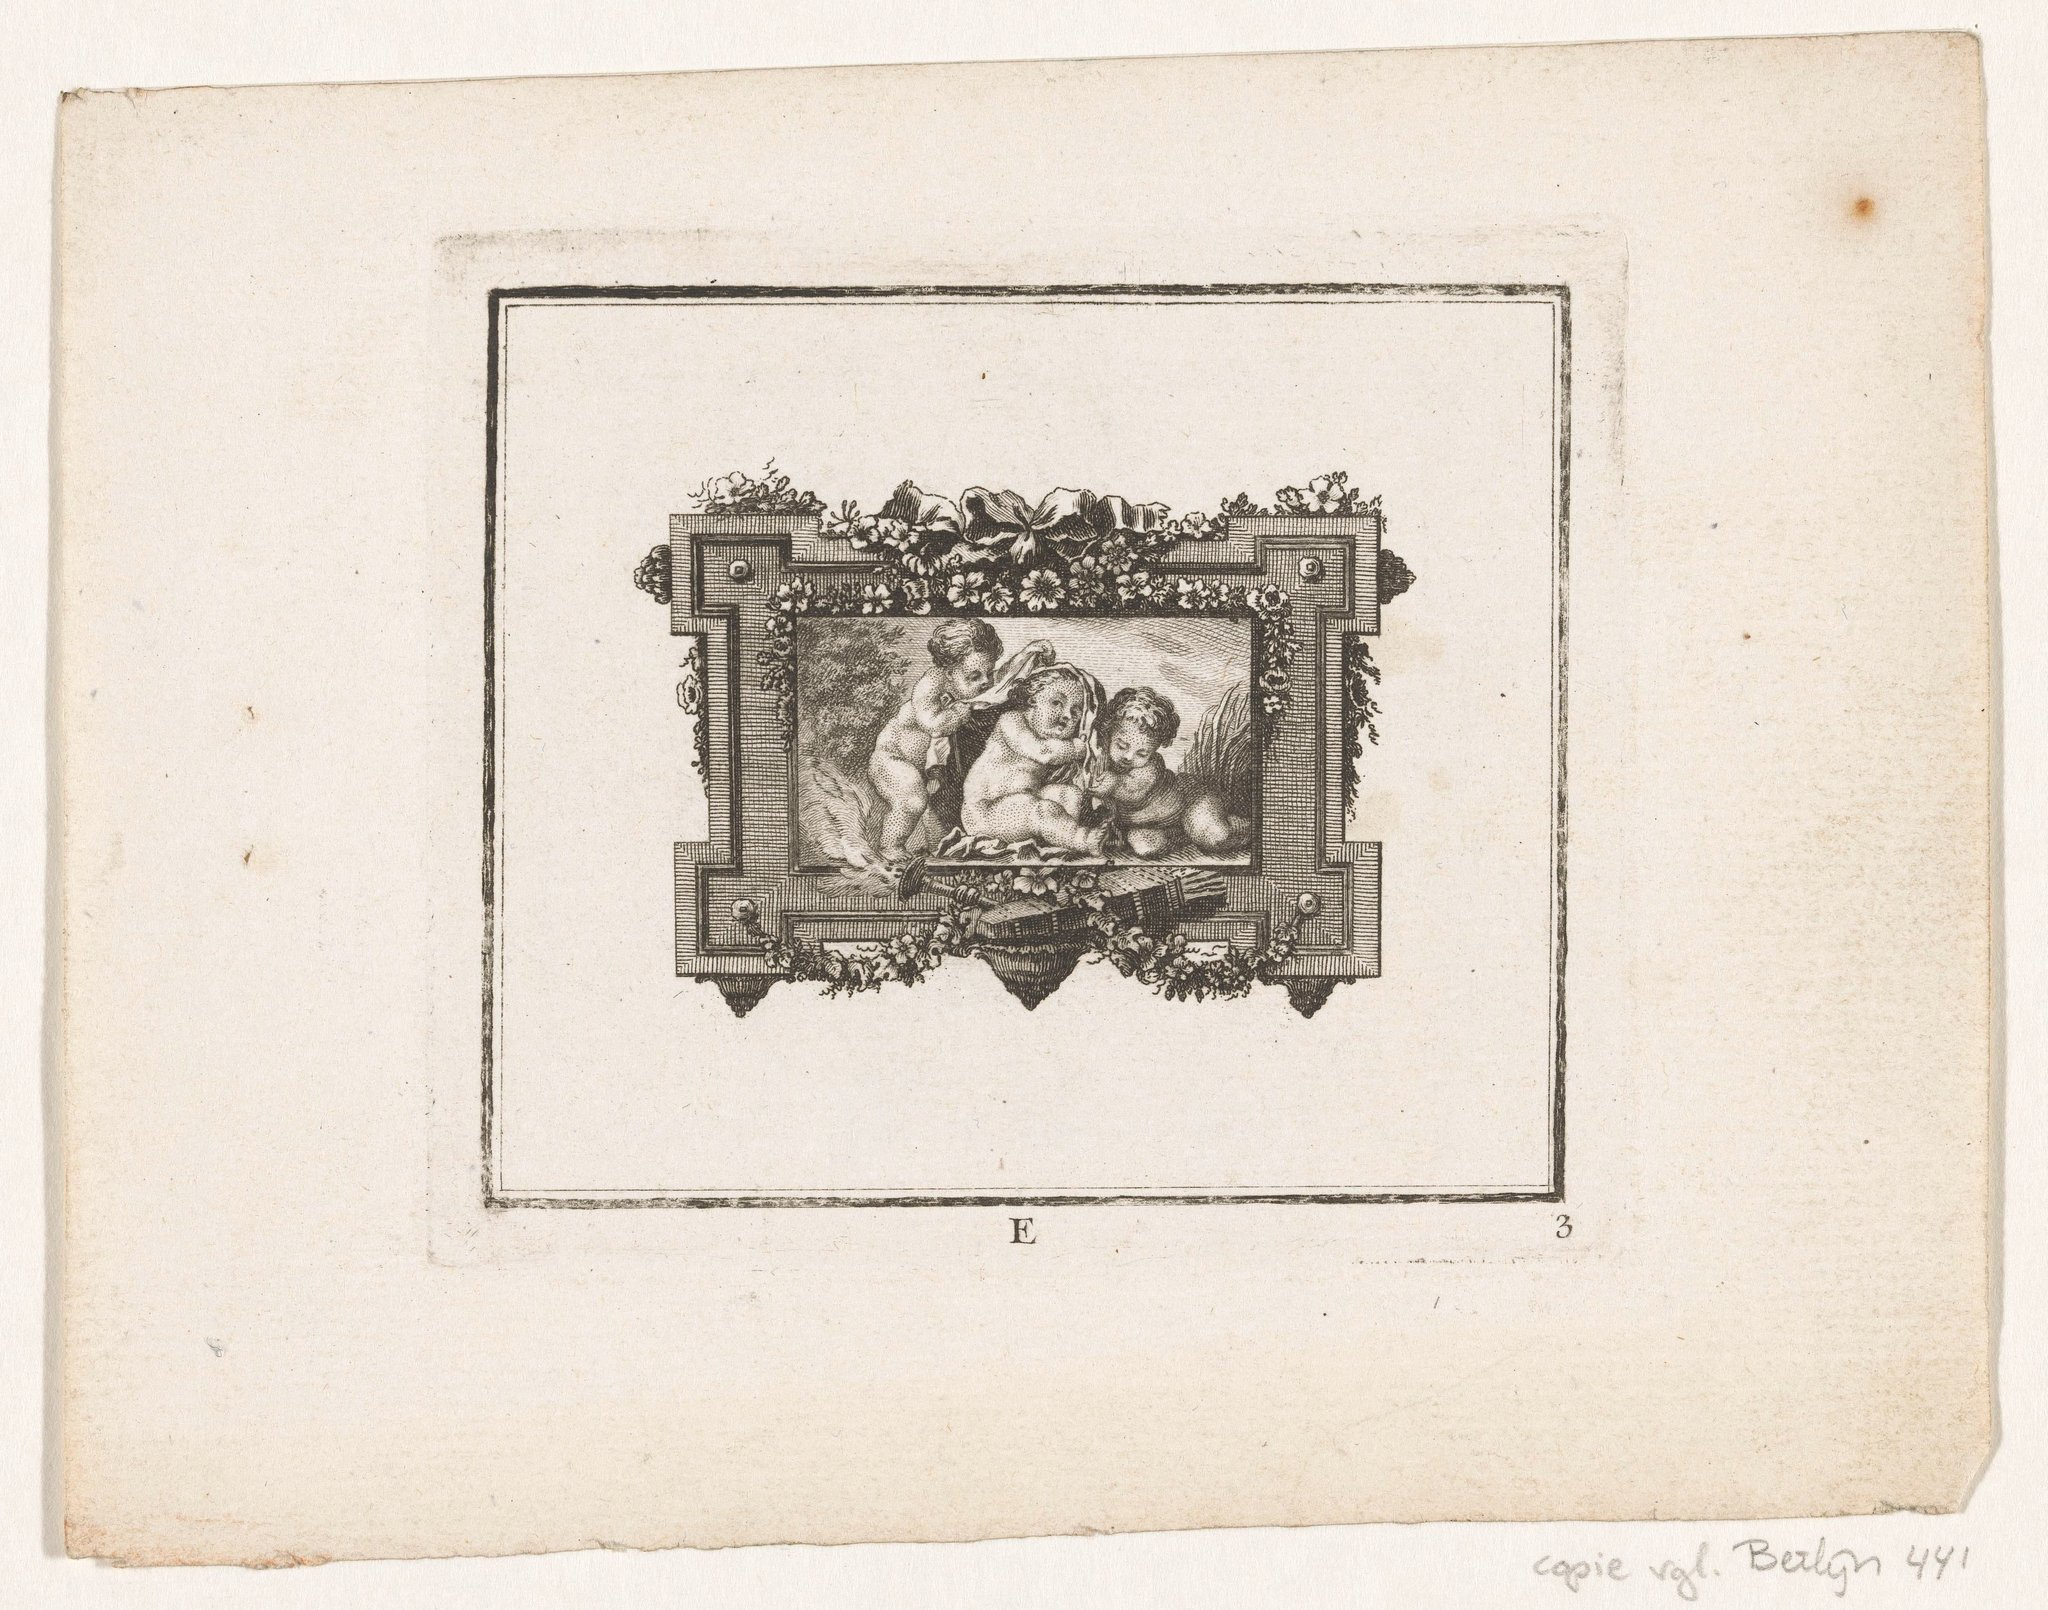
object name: print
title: E Culs de Lampe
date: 1730-1778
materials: paper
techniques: engraving, etching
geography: paris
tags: vignette, cupids: 'amores', 'amoretti', 'putti'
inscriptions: collector's mark: Lugt 2228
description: Vignet met drie putti met een doek in een rechthoekige omlijsting.